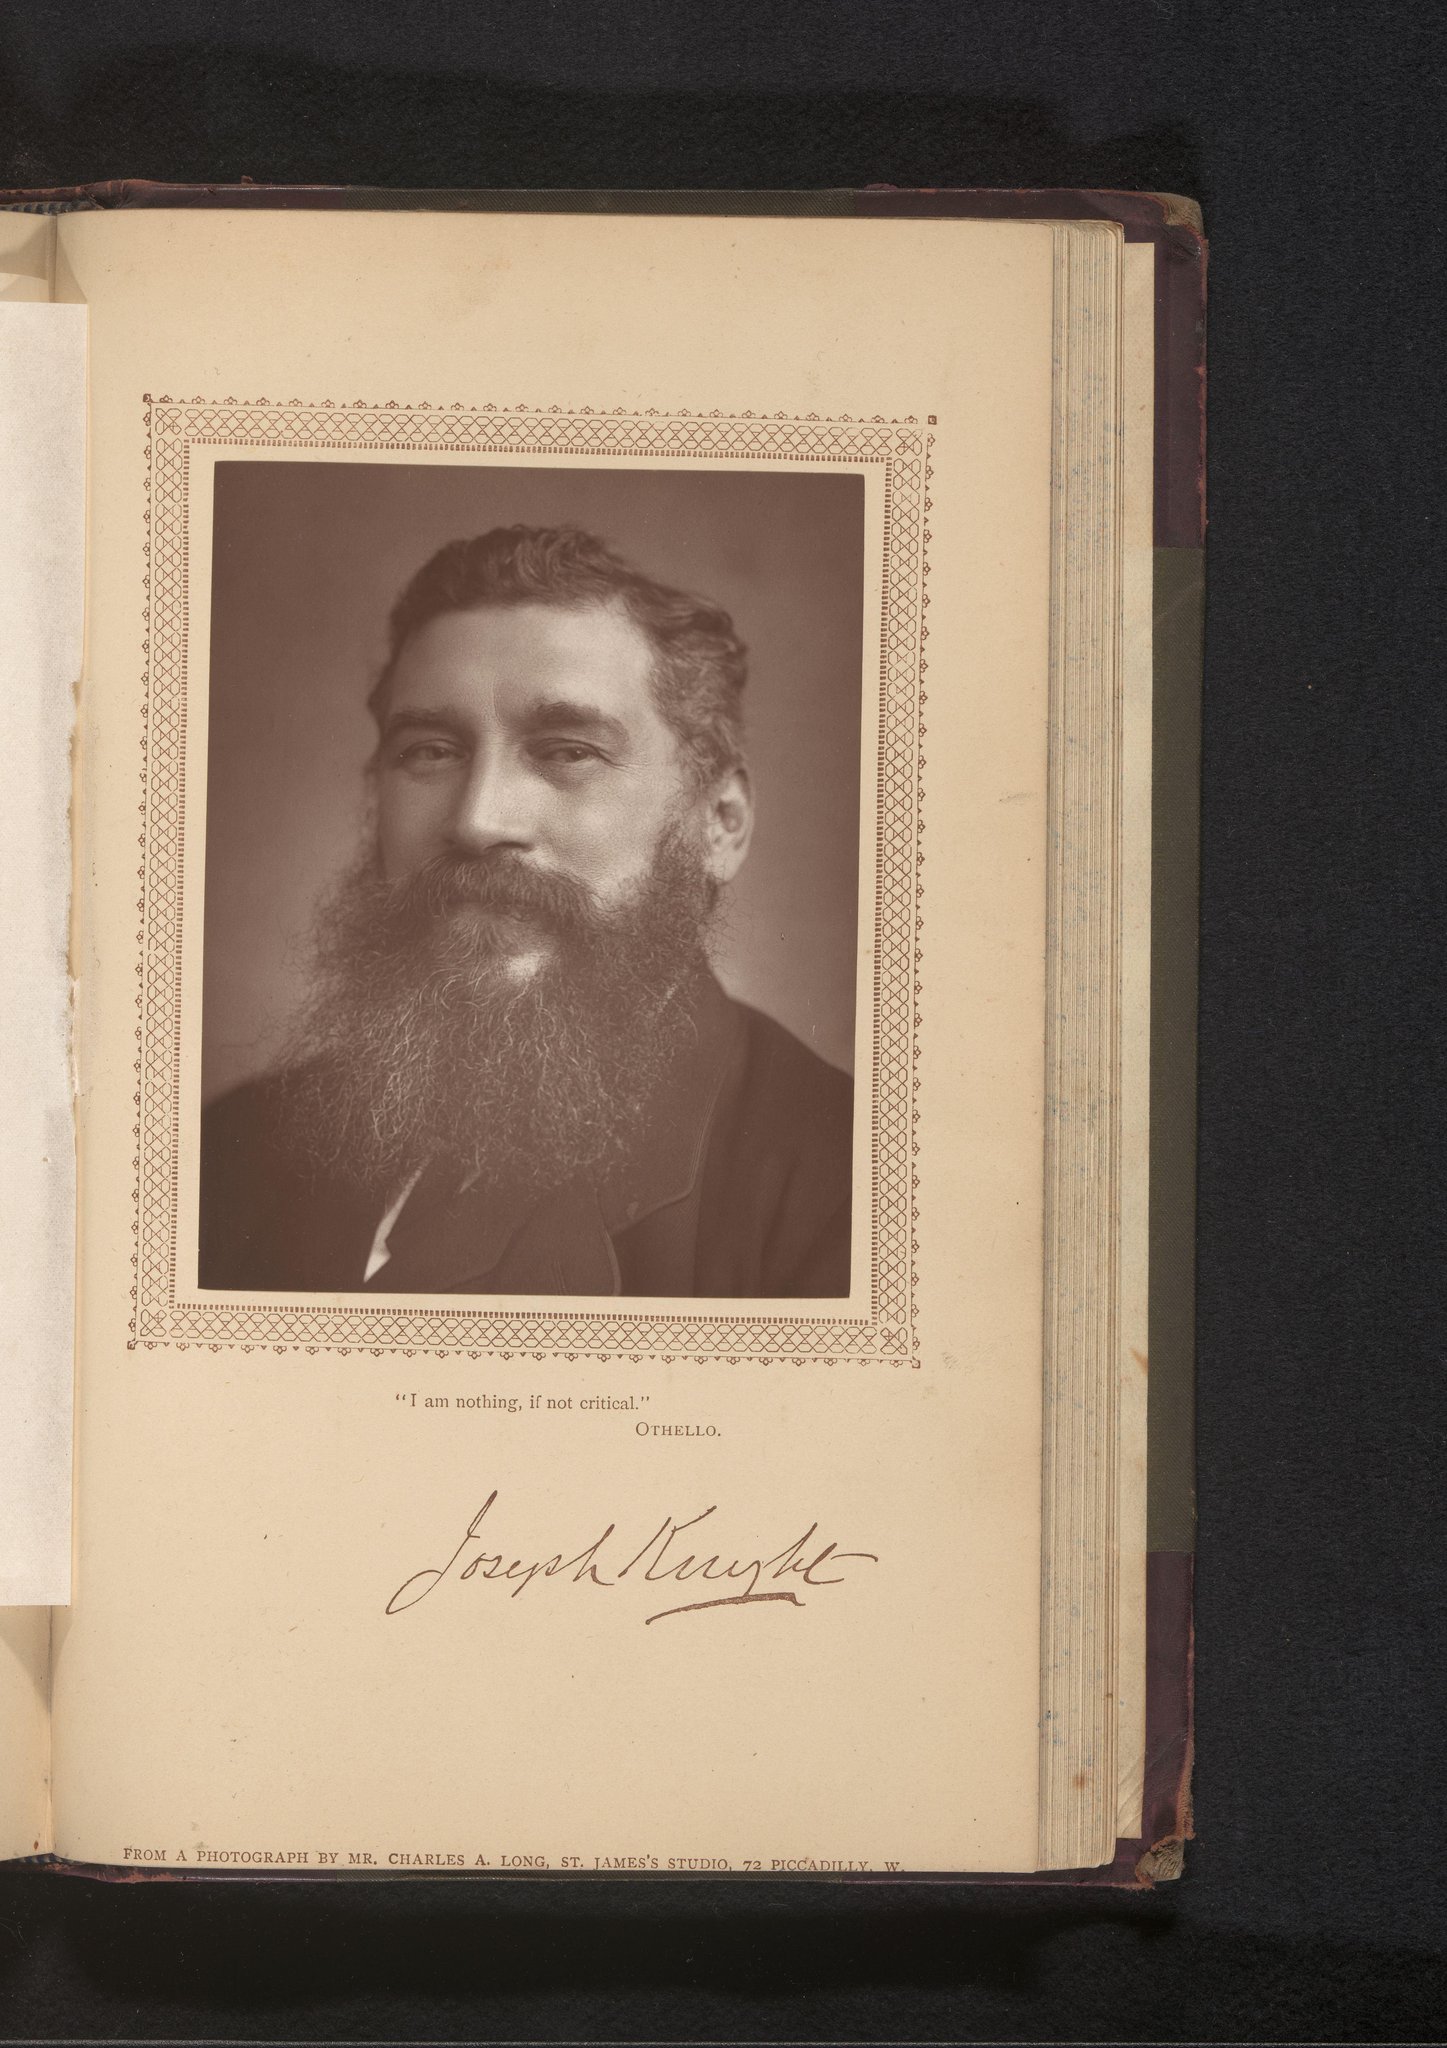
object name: photomechanical print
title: Portret van Joseph Knight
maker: Anonymous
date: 1879-1884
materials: paper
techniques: woodburytype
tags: adult man, historical persons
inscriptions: inscription: ‘'I am nothing if not critical.'/ Othello’, signature: ‘Joseph Knight’